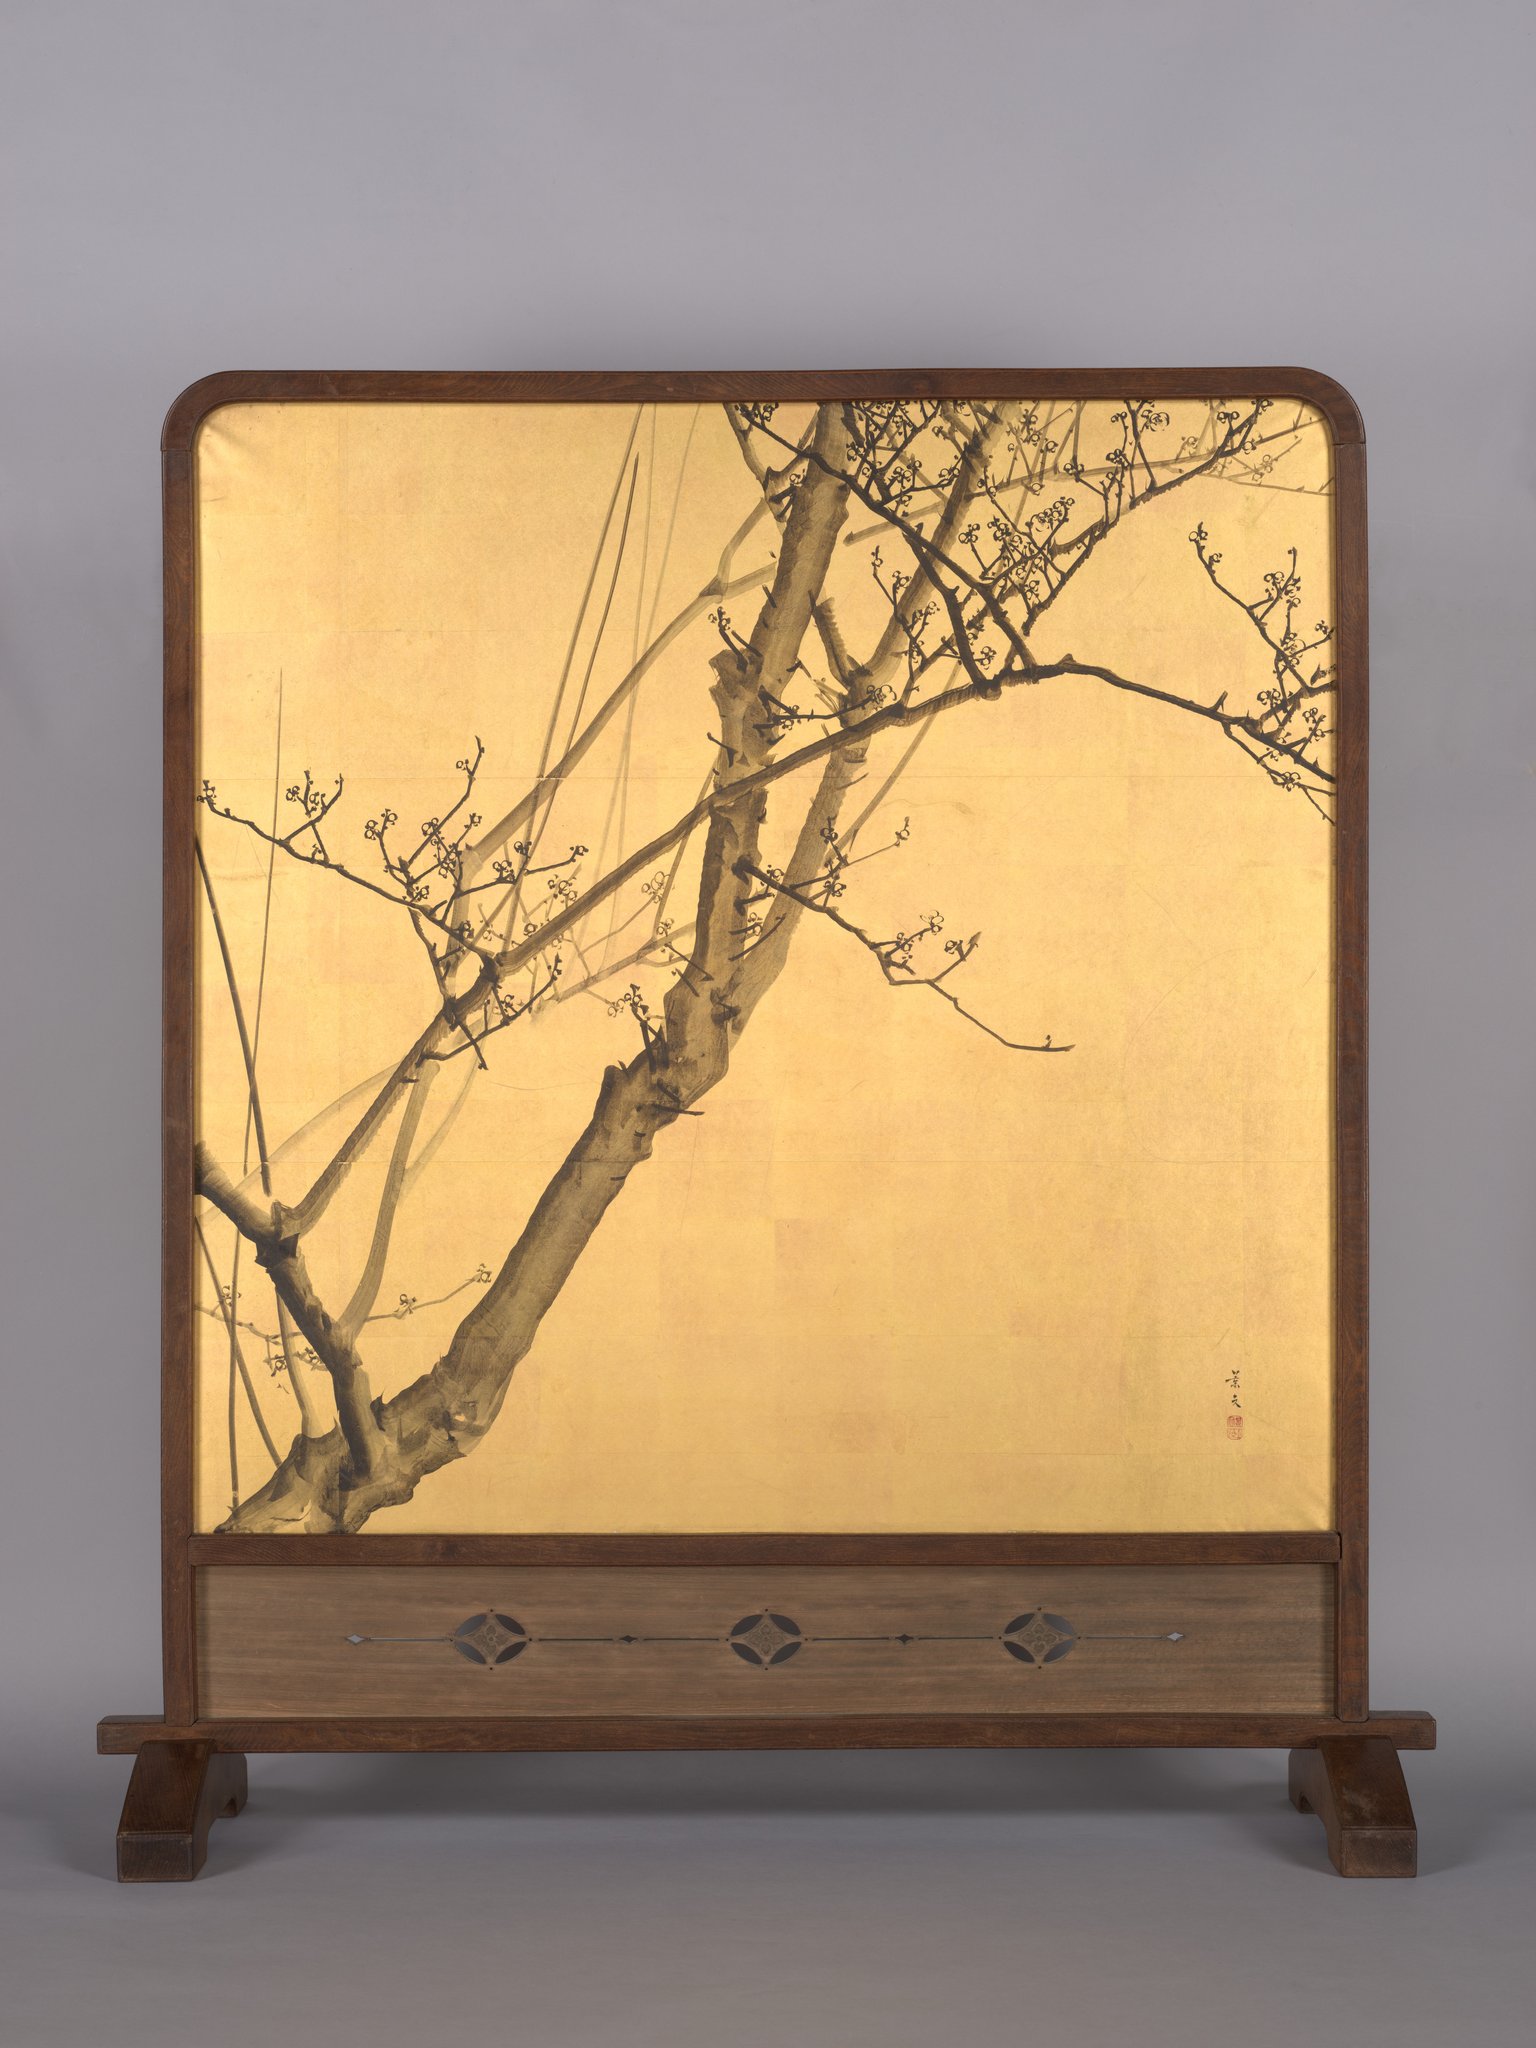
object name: screen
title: Plum Blossoms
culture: japanese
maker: matsumura keibun 松村景文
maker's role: artist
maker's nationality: japanese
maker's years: 1779-1843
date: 1823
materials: ink, paper